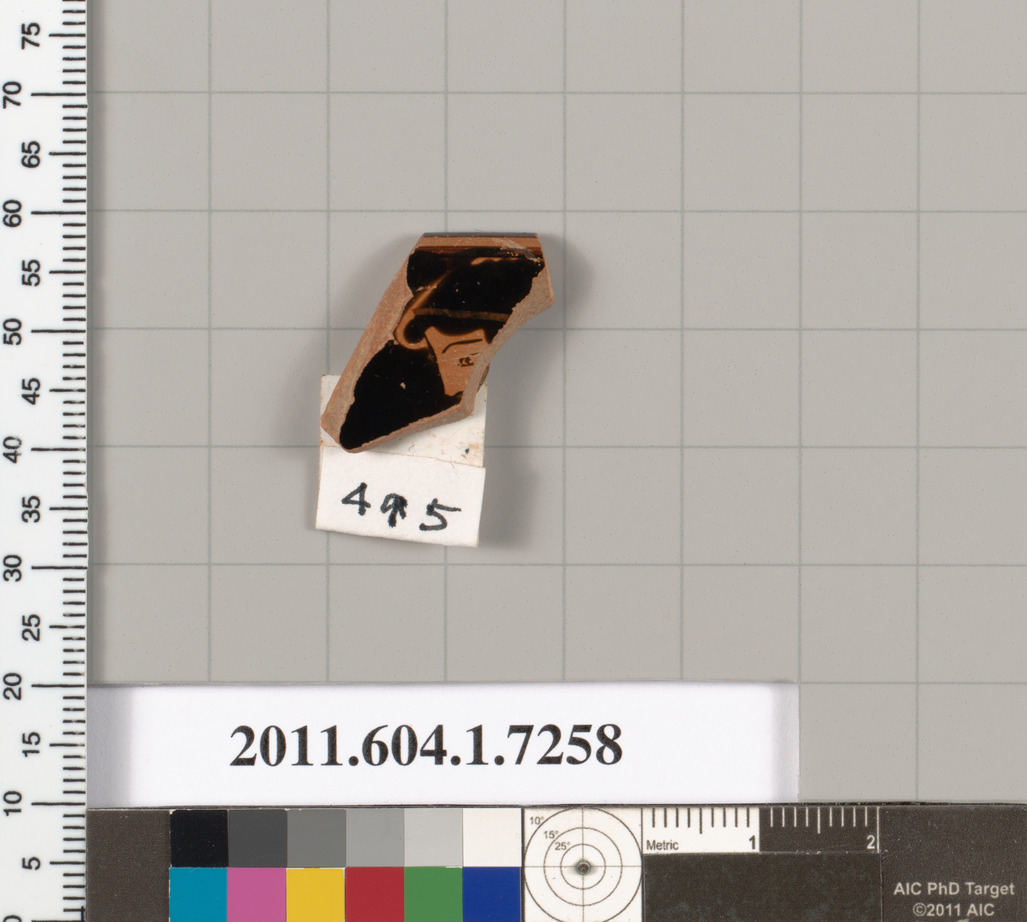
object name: kylix fragment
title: Terracotta rim fragment of a kylix (drinking cup)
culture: greek, attic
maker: makron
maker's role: artist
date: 500-480 BCE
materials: terracotta